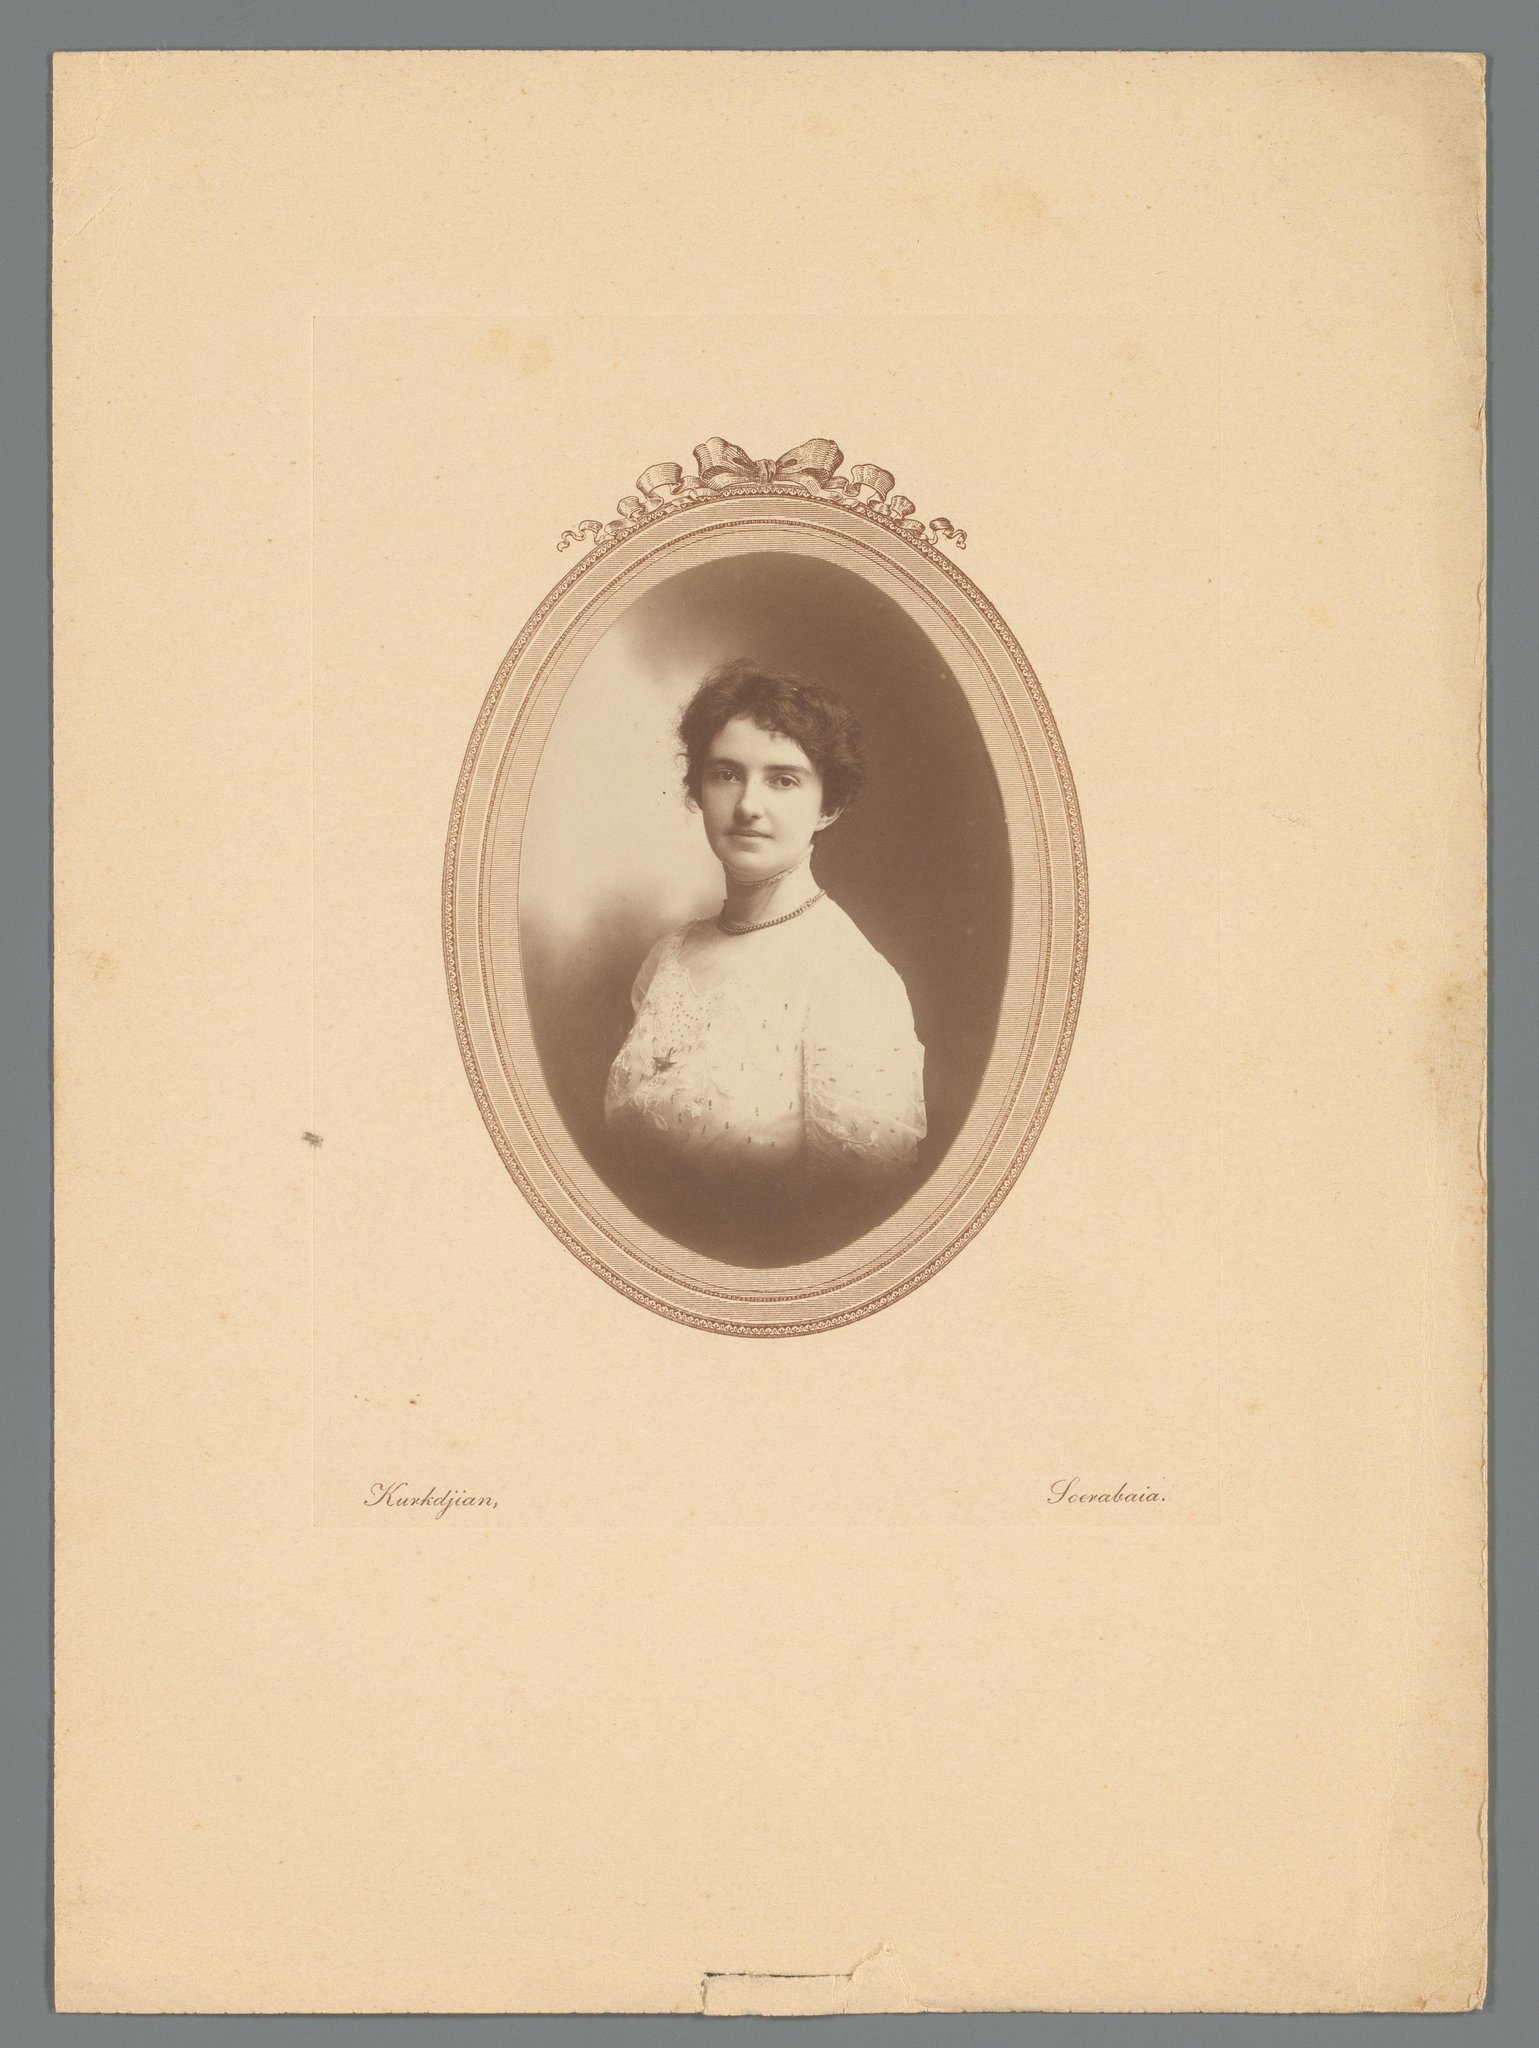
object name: photograph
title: Ovaal portret van een vrouw, Soerabaja, Nederlands-Indië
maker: onnes kurkdjian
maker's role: fotograaf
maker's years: 1851-1903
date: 1880-1910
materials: cardboard, photographic support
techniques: albumen print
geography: surabaya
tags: surabaya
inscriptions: inscription: ‘Kurkdjian, Soerabaia.’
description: Ovaal portret met een gedrukte sierlijst eromheen van een blanke vrouw met donker opgestoken haar en hooggesloten witte bloes, Soerabaja, Nederlands-Indië